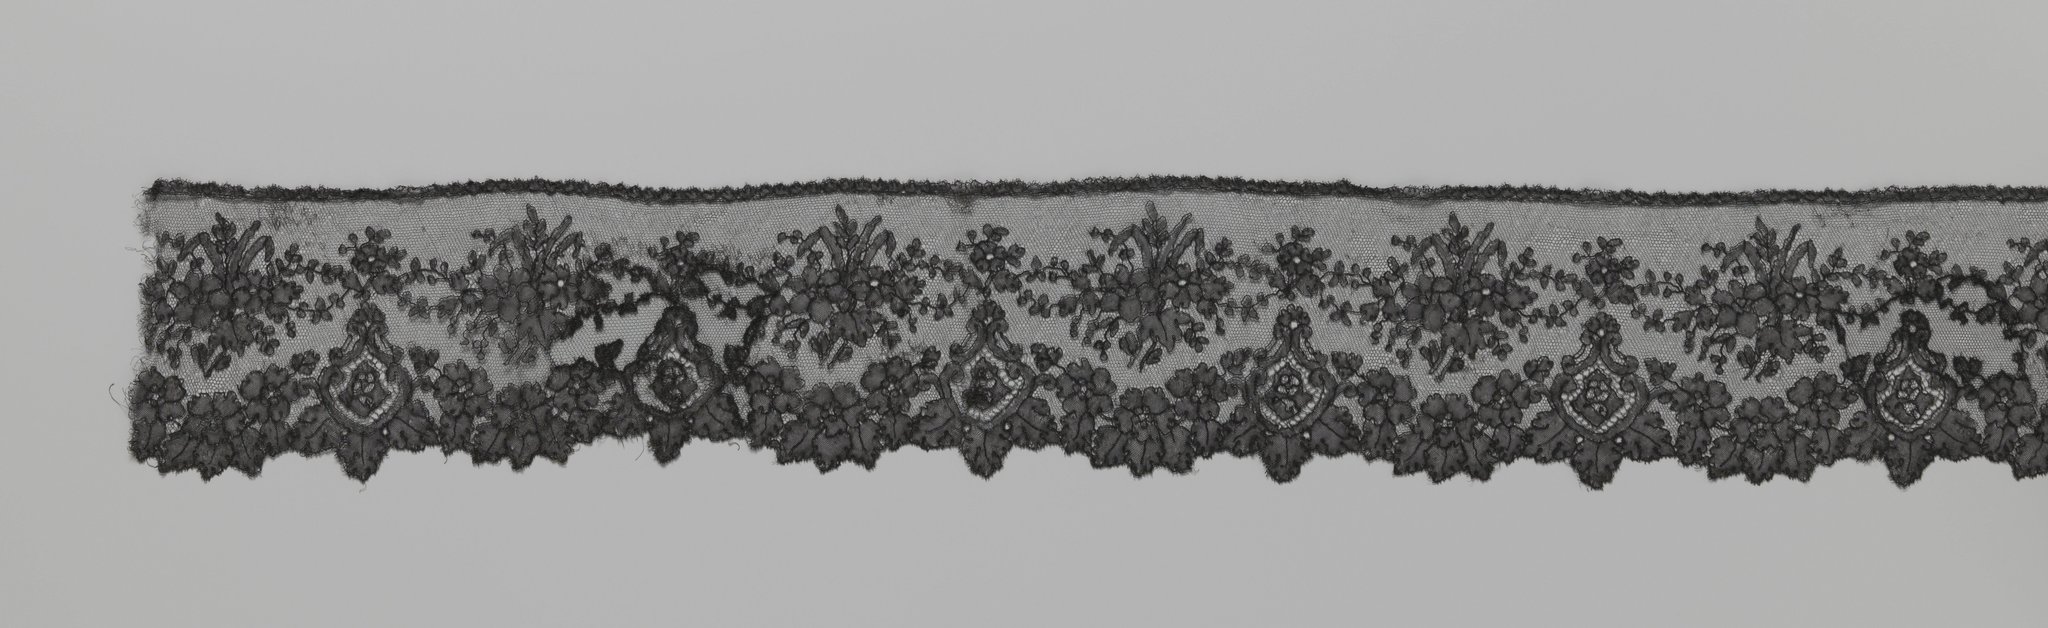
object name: strip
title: Japonstrook van kloskant met de schildvormige medaillons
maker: Anonymous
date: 1850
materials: silk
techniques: lace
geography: bayeux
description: Japonstrook van zwarte kloskant: Chantilly-kant. Op een open mazenfond staan gesloten motieven los van elkaar gegroepeerd. Op de knooppunten der schulpen rijzen drie symmetrische schildvormige medaillons op, die gevat zijn in twee paar c-voluten. Boven de schulpen komt een grote, boven de medaillons een kleine bloemtoef voor, met geknakte bloembladeren als bekroning. De binnenrand is versierd met een keten van hartvormige blaadjes.